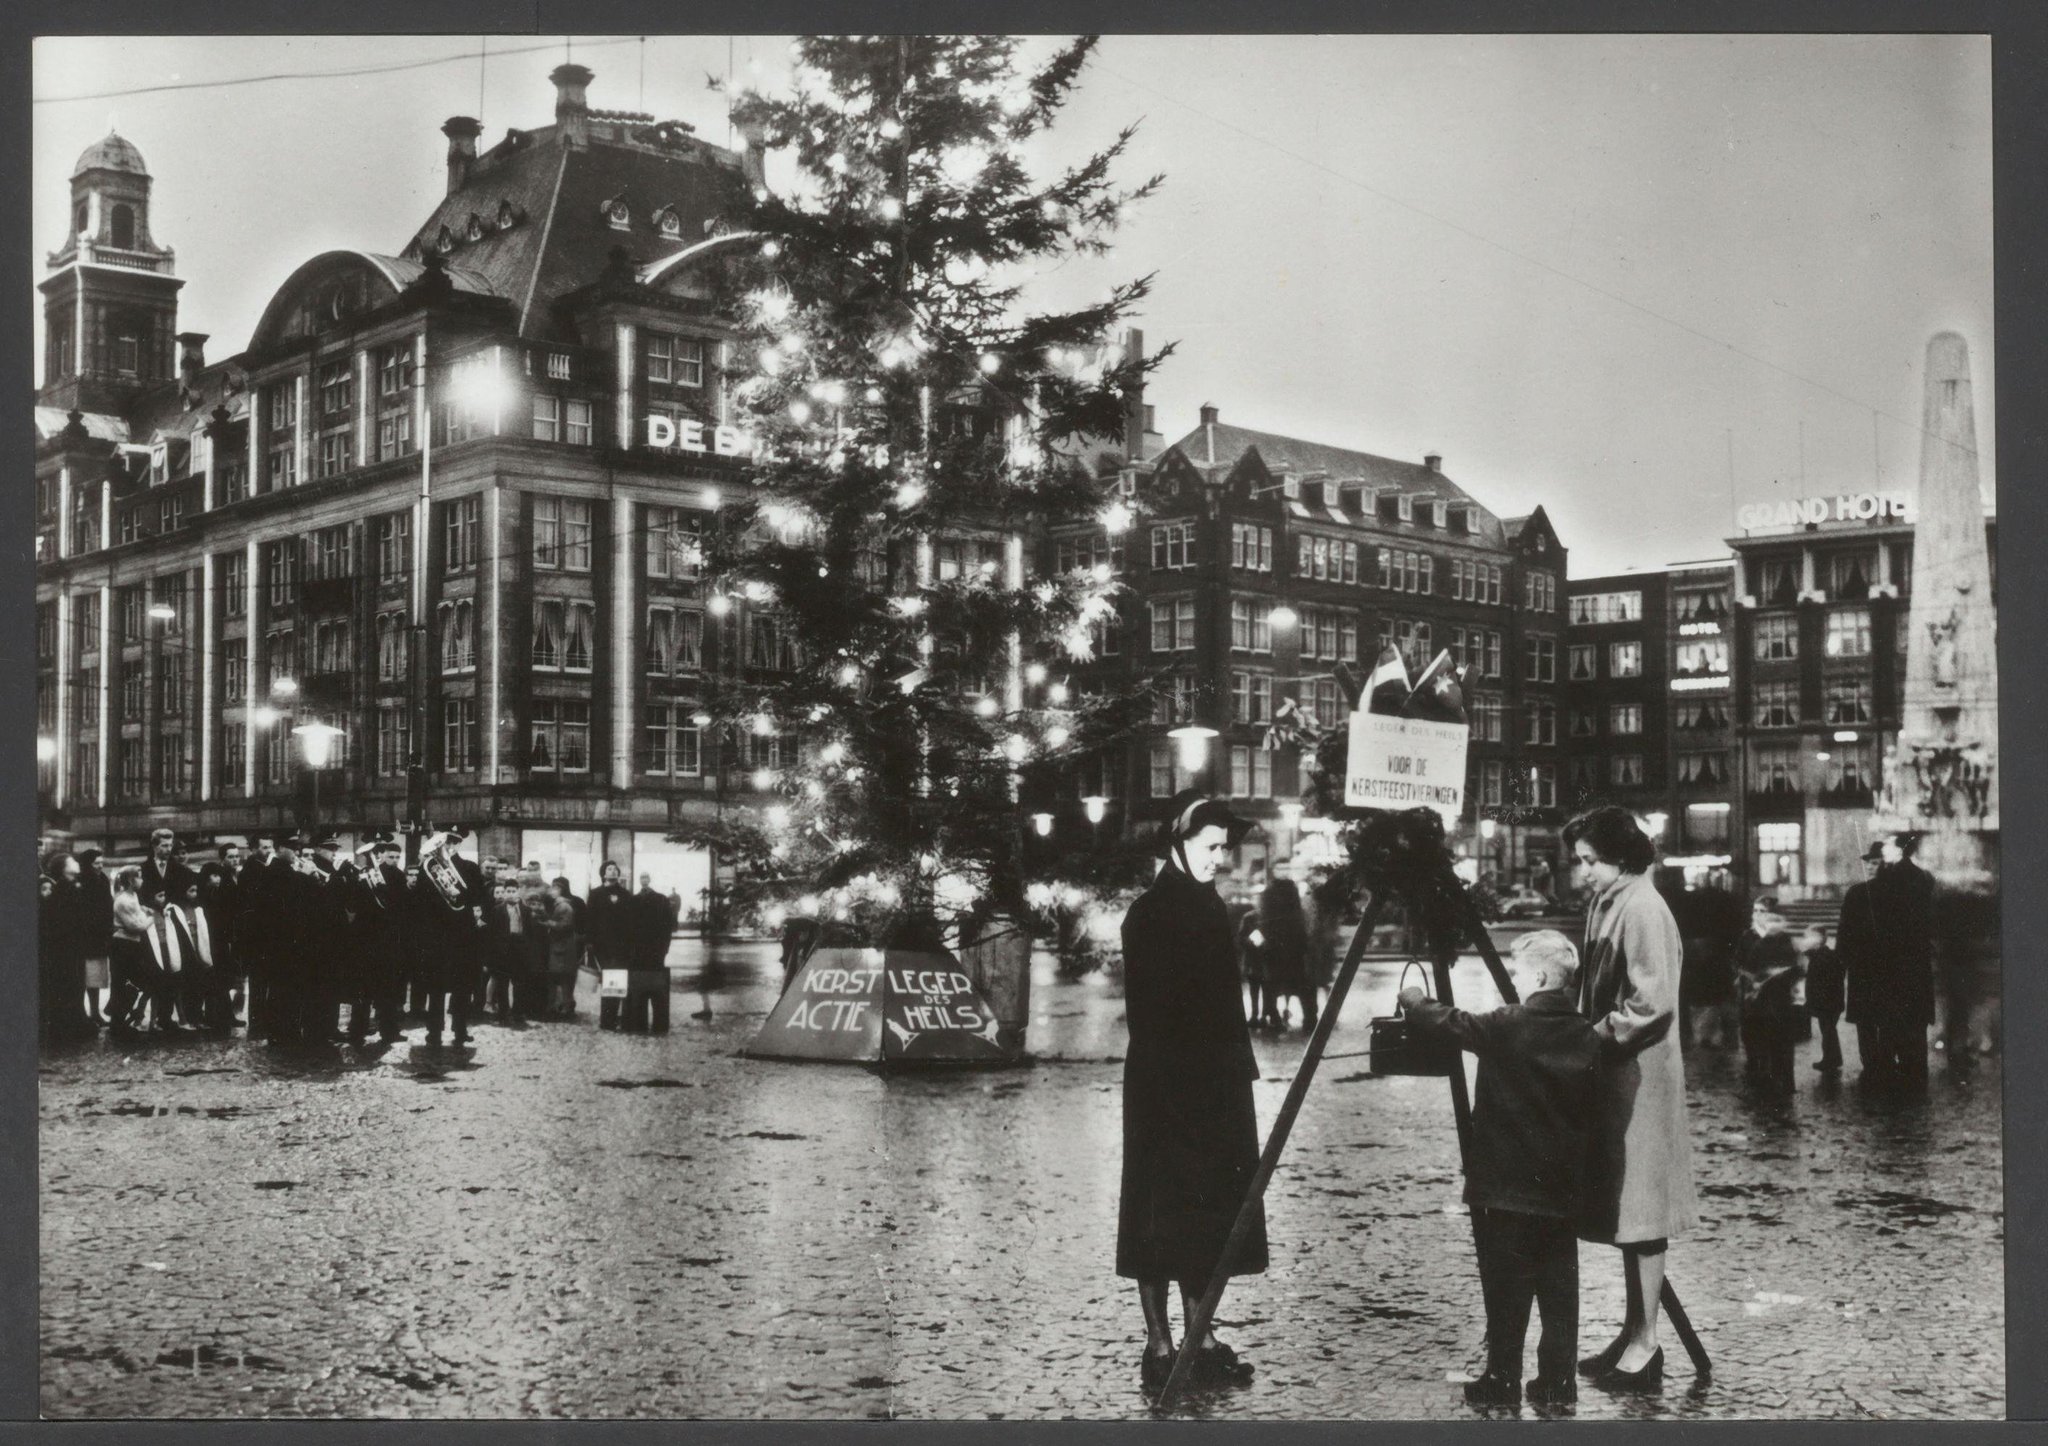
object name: photograph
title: Gezicht op de kerstboom op de Dam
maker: Anonymous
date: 1963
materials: paper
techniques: gelatin silver print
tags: square, place, circus, etc., christmas tree, city-view in general; 'veduta'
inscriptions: inscription: ‘Geschenk Mej M. [...] Amsterdam’, collector's mark: ‘7’ Lugt 1641b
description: Onderwerpsrubriek binnen de Atlas Amsterdam: Dam (na 1835).